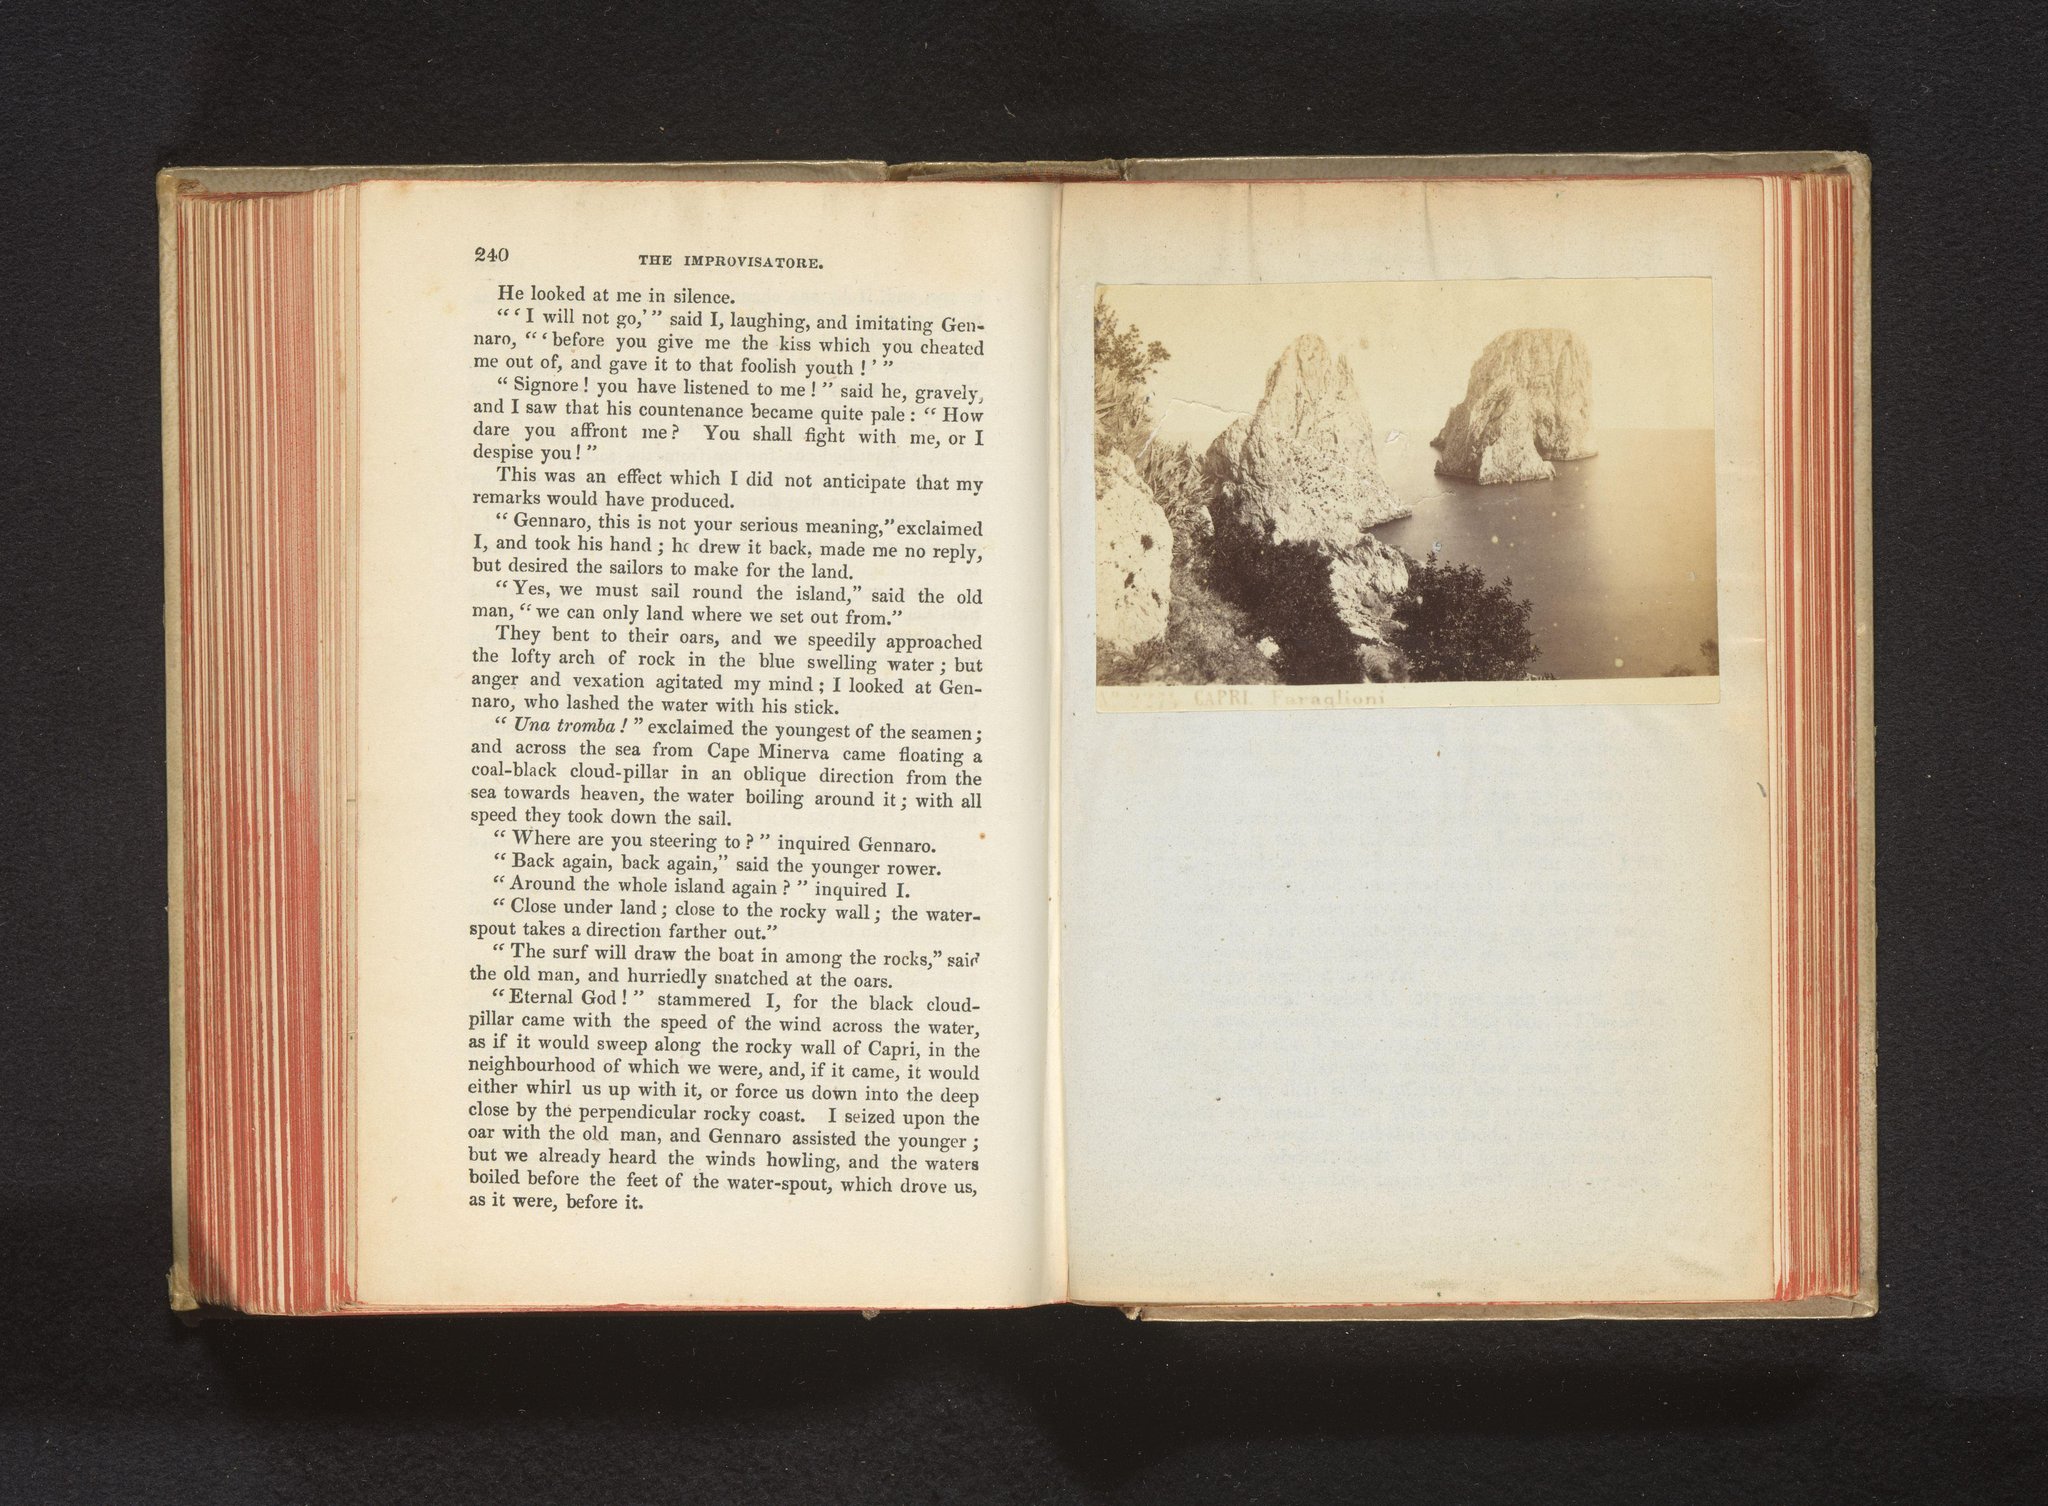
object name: photograph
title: Capri. Faraglioni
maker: Anonymous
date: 1863-1873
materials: photographic support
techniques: albumen print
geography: capri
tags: rocky coast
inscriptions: number: ‘No 2274’